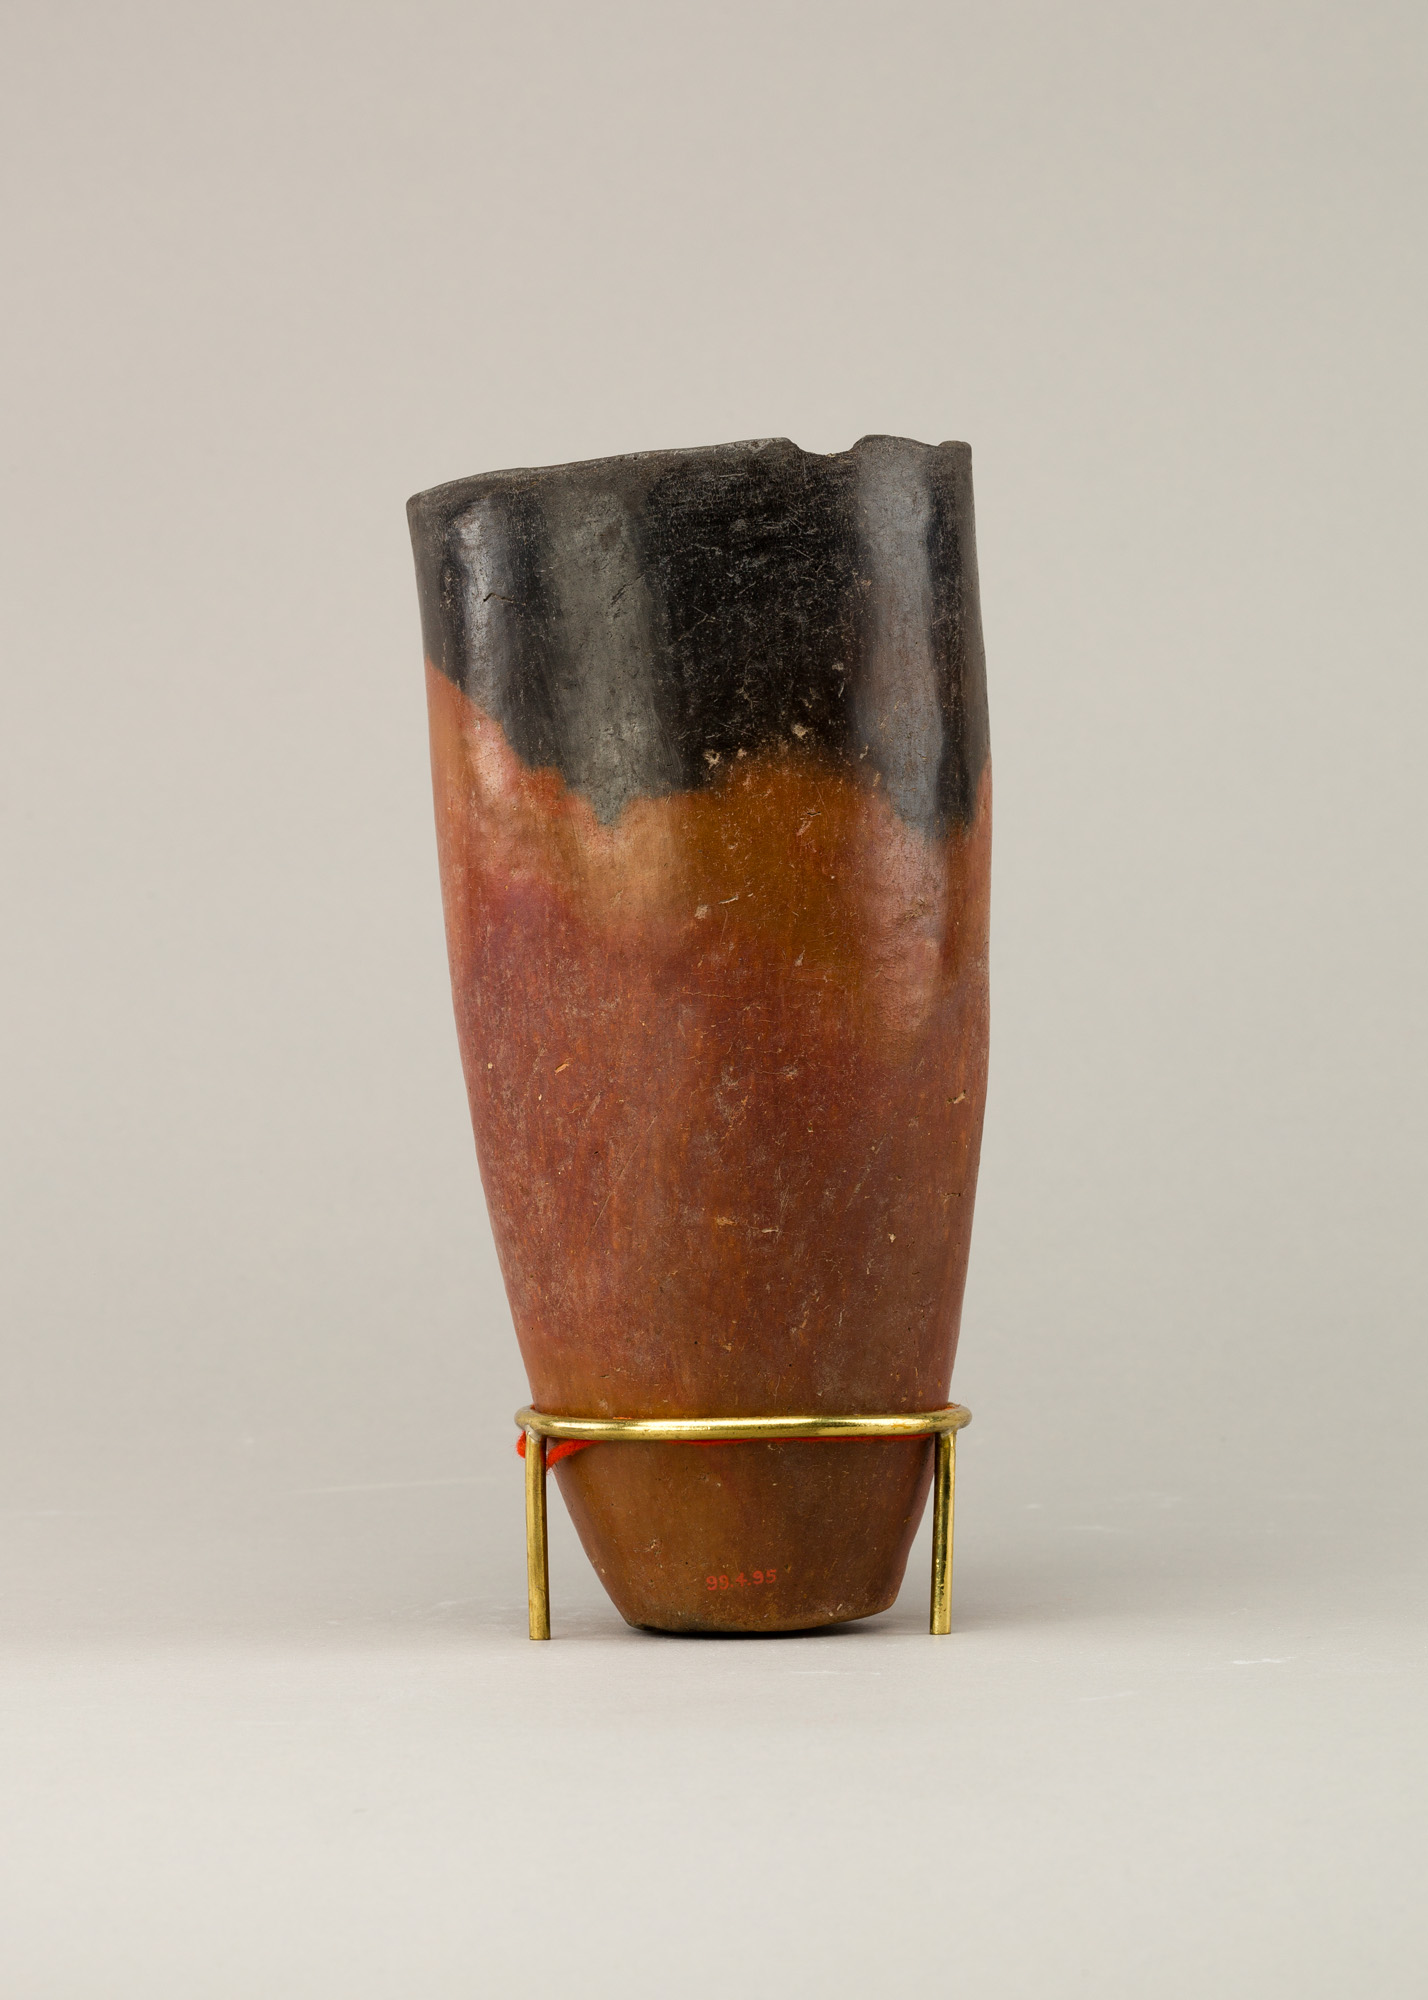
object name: beaker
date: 3850-2960 BCE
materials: pottery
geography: egypt